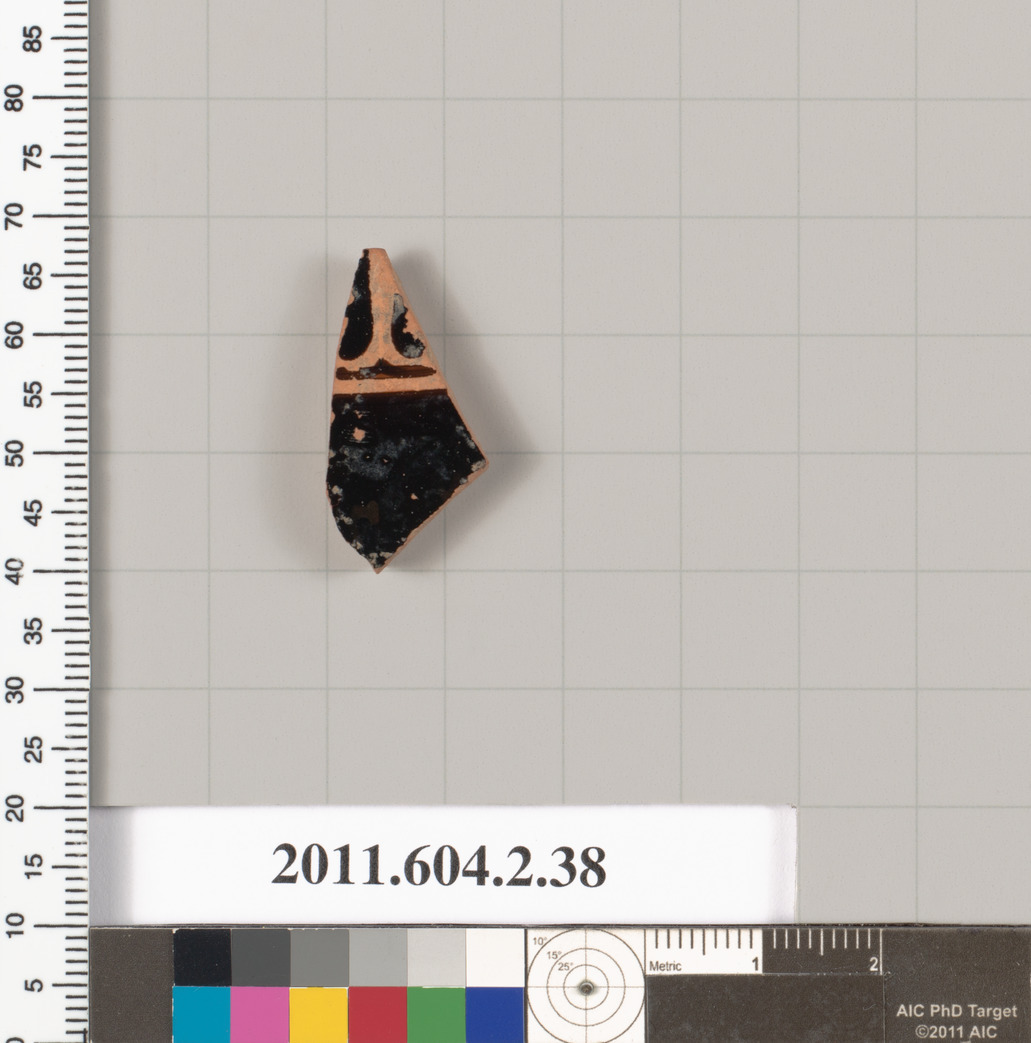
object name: psykter fragment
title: Terracotta fragment of a psykter (vase for cooling wine)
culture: greek, attic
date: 534-468 BCE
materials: terracotta